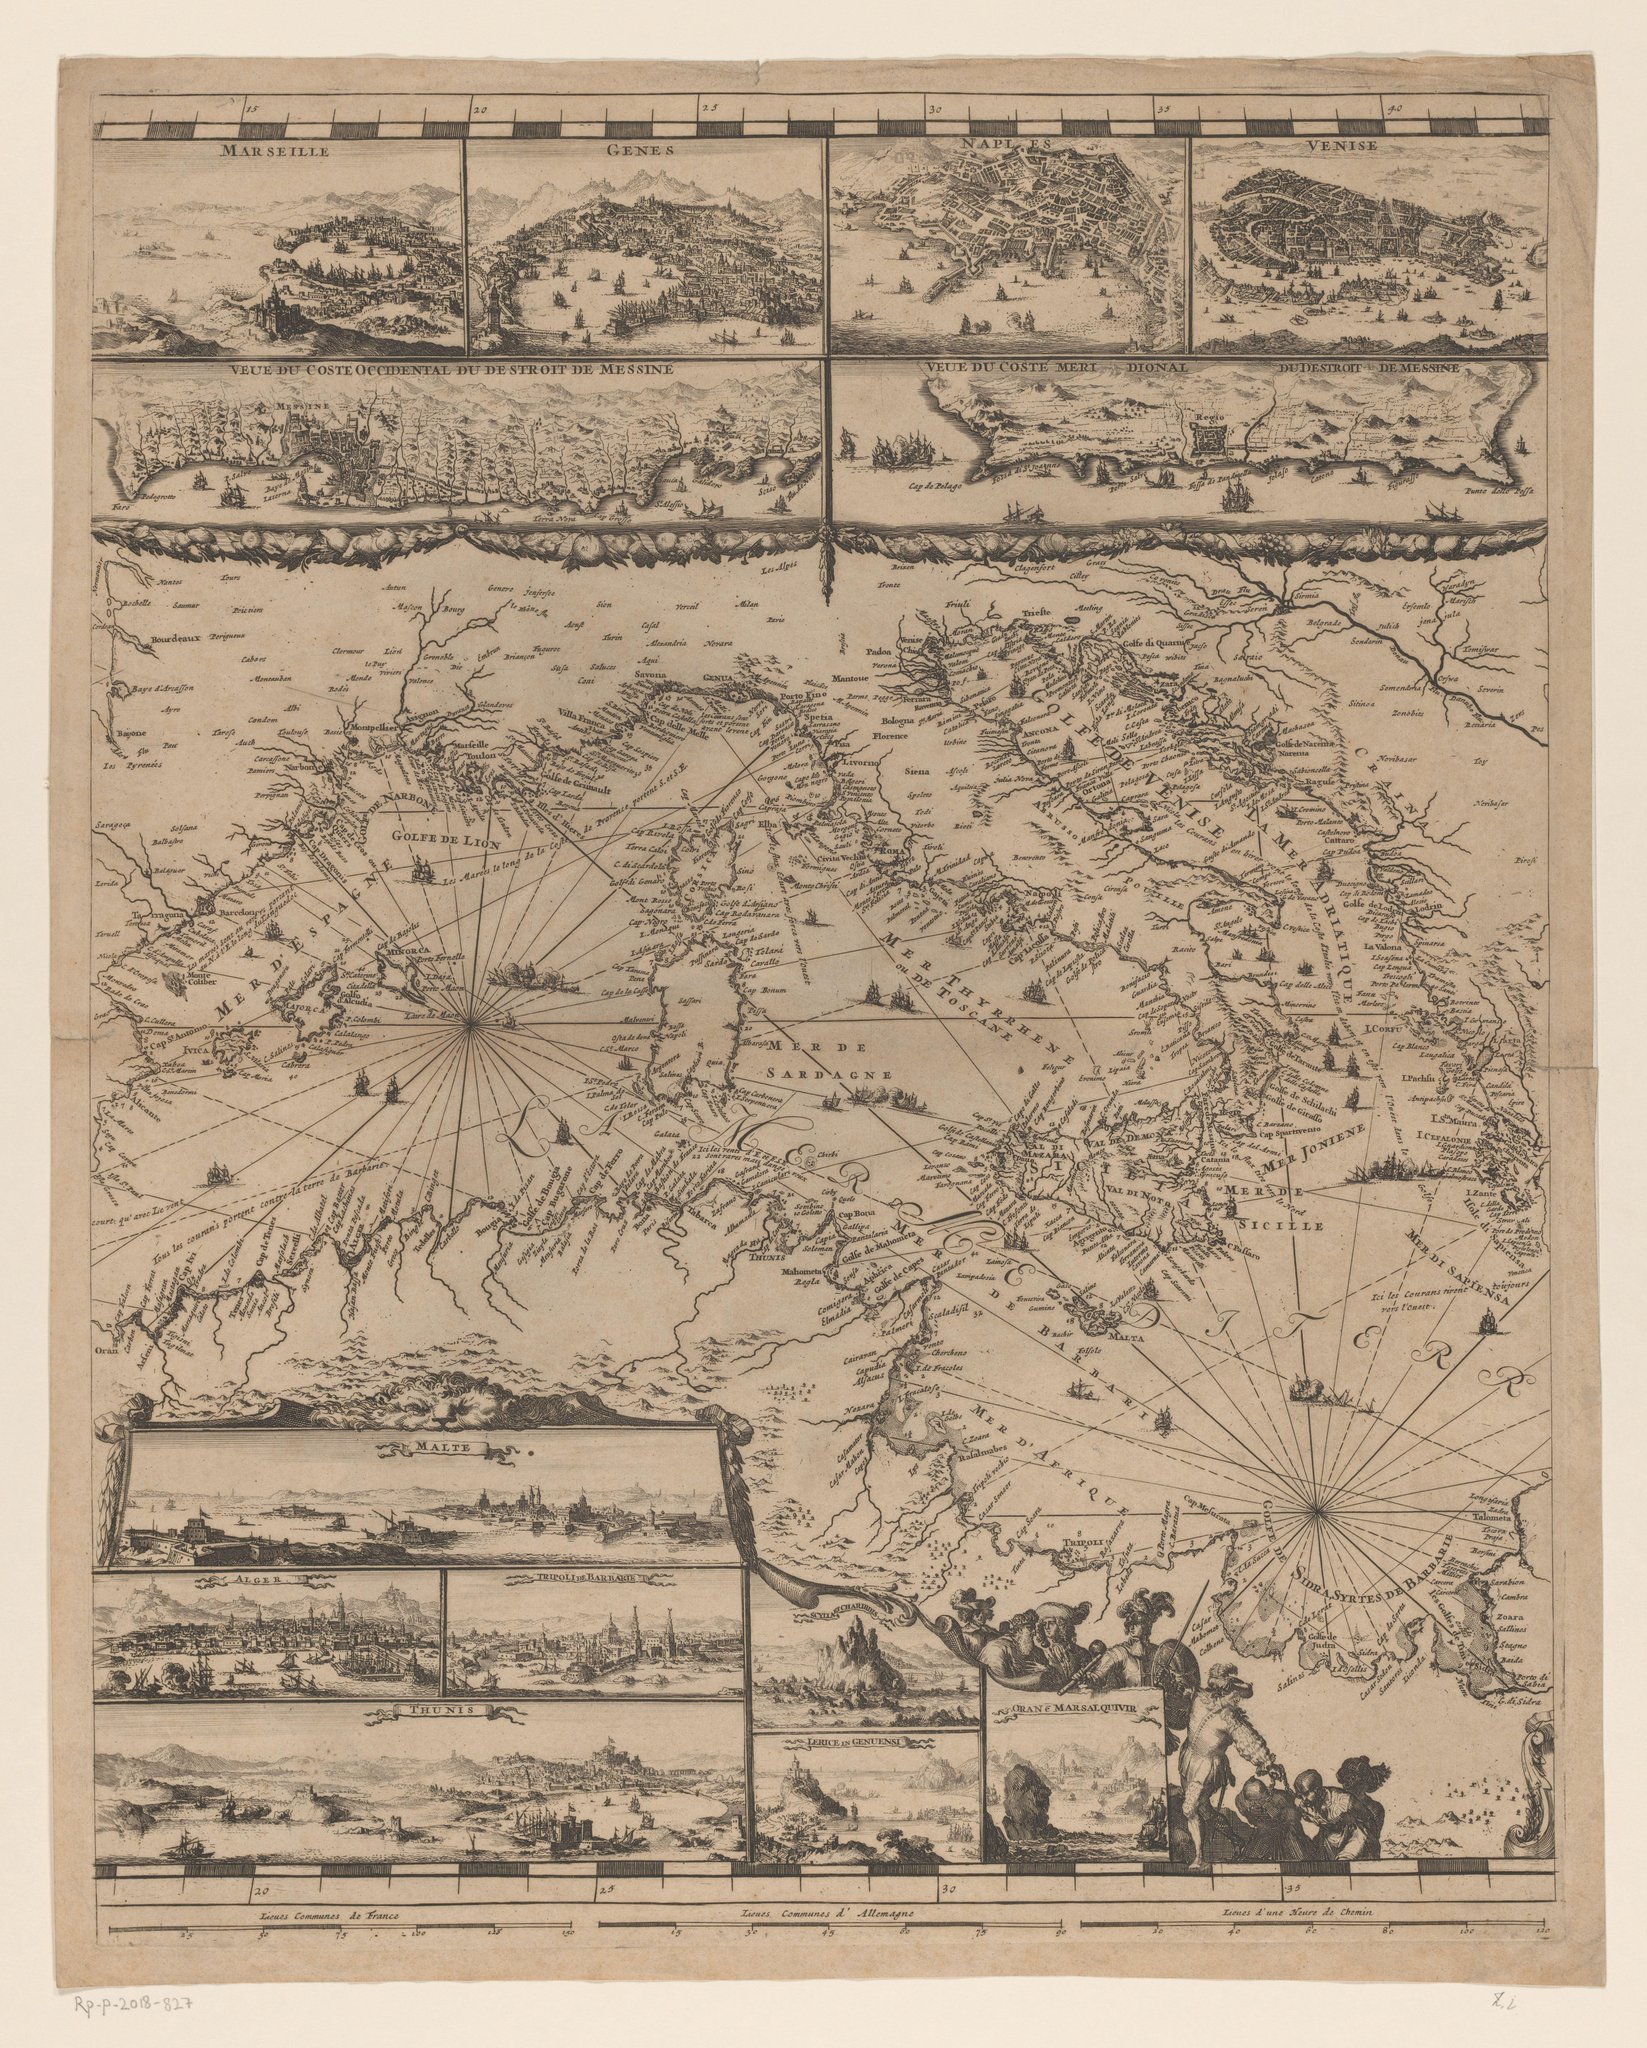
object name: map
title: Carte nouvelle de la Mer Mediterranee ou sont exactement remarqués (...)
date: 1694-1700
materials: paper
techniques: etching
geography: amsterdam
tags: marine charts, prospect of city, town panorama, silhouette of city, marseille, venice, naples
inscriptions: collector's mark: Lugt 2228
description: Prent ook gebruikt in: Le Neptune François, Ou Atlas Nouveau des Cartes Marines. Amsterdam: Pieter Mortier (I), 1694. En in: Le Neptune François, Ou Atlas Nouveau des Cartes Marines. Amsterdam: Pieter Mortier (I), 1700.